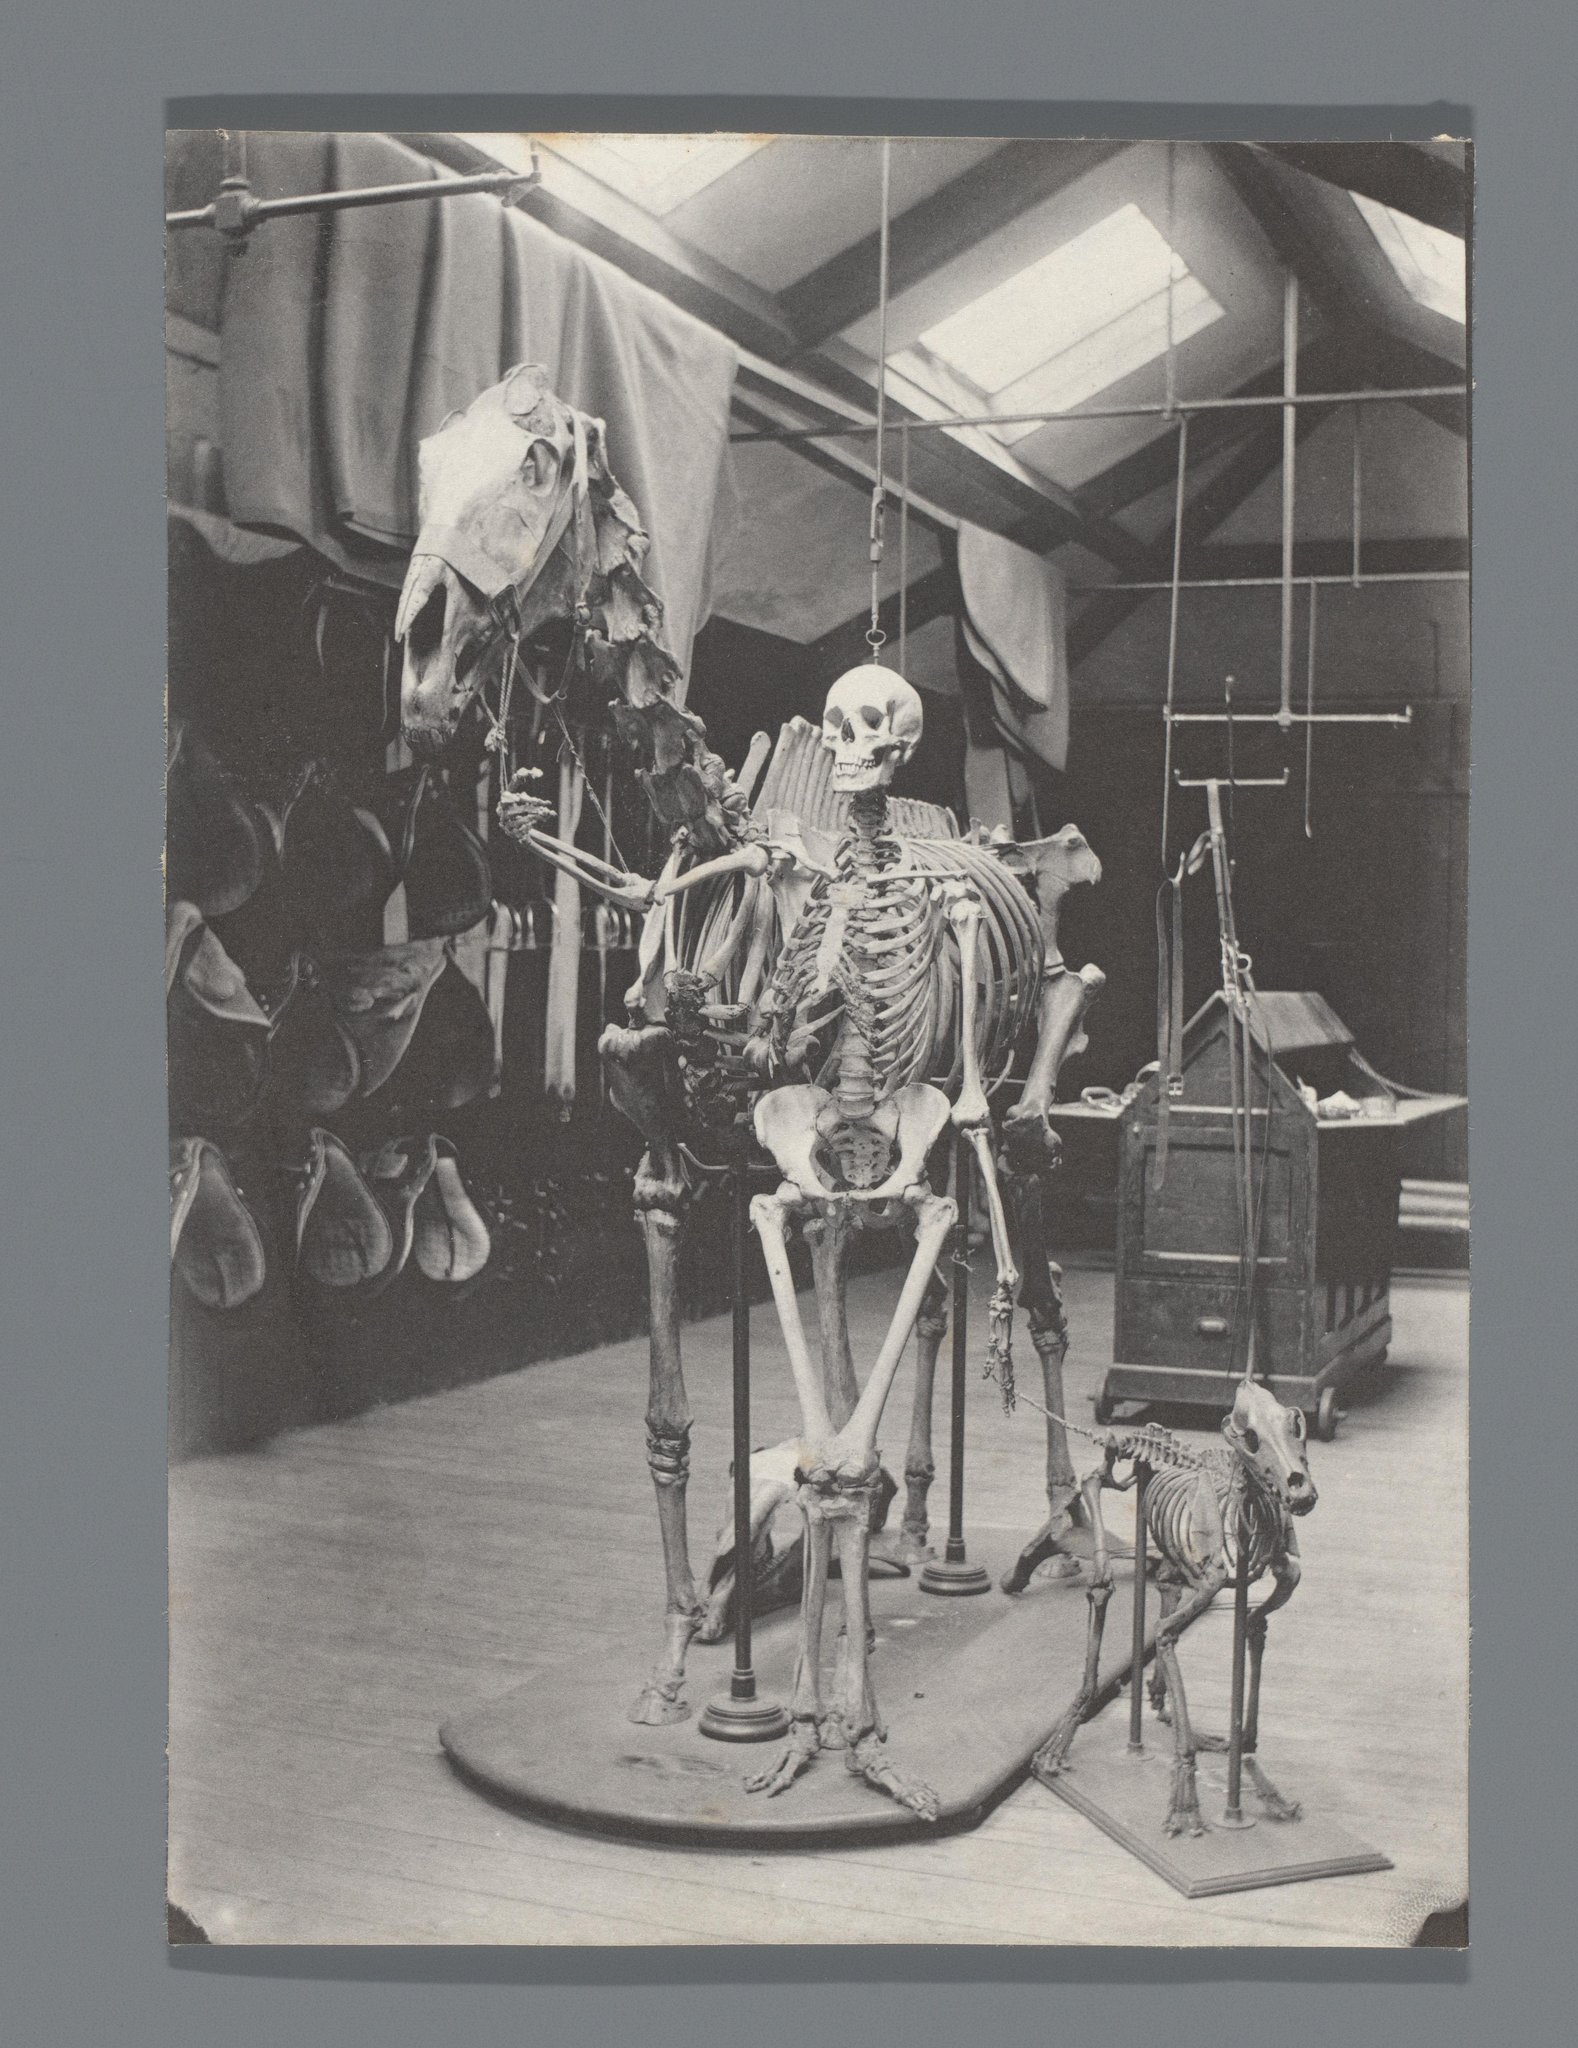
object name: photograph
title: Drie skeletten: een paard, een mens en een hond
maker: Anonymous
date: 1900-1925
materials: photographic support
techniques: platinum process